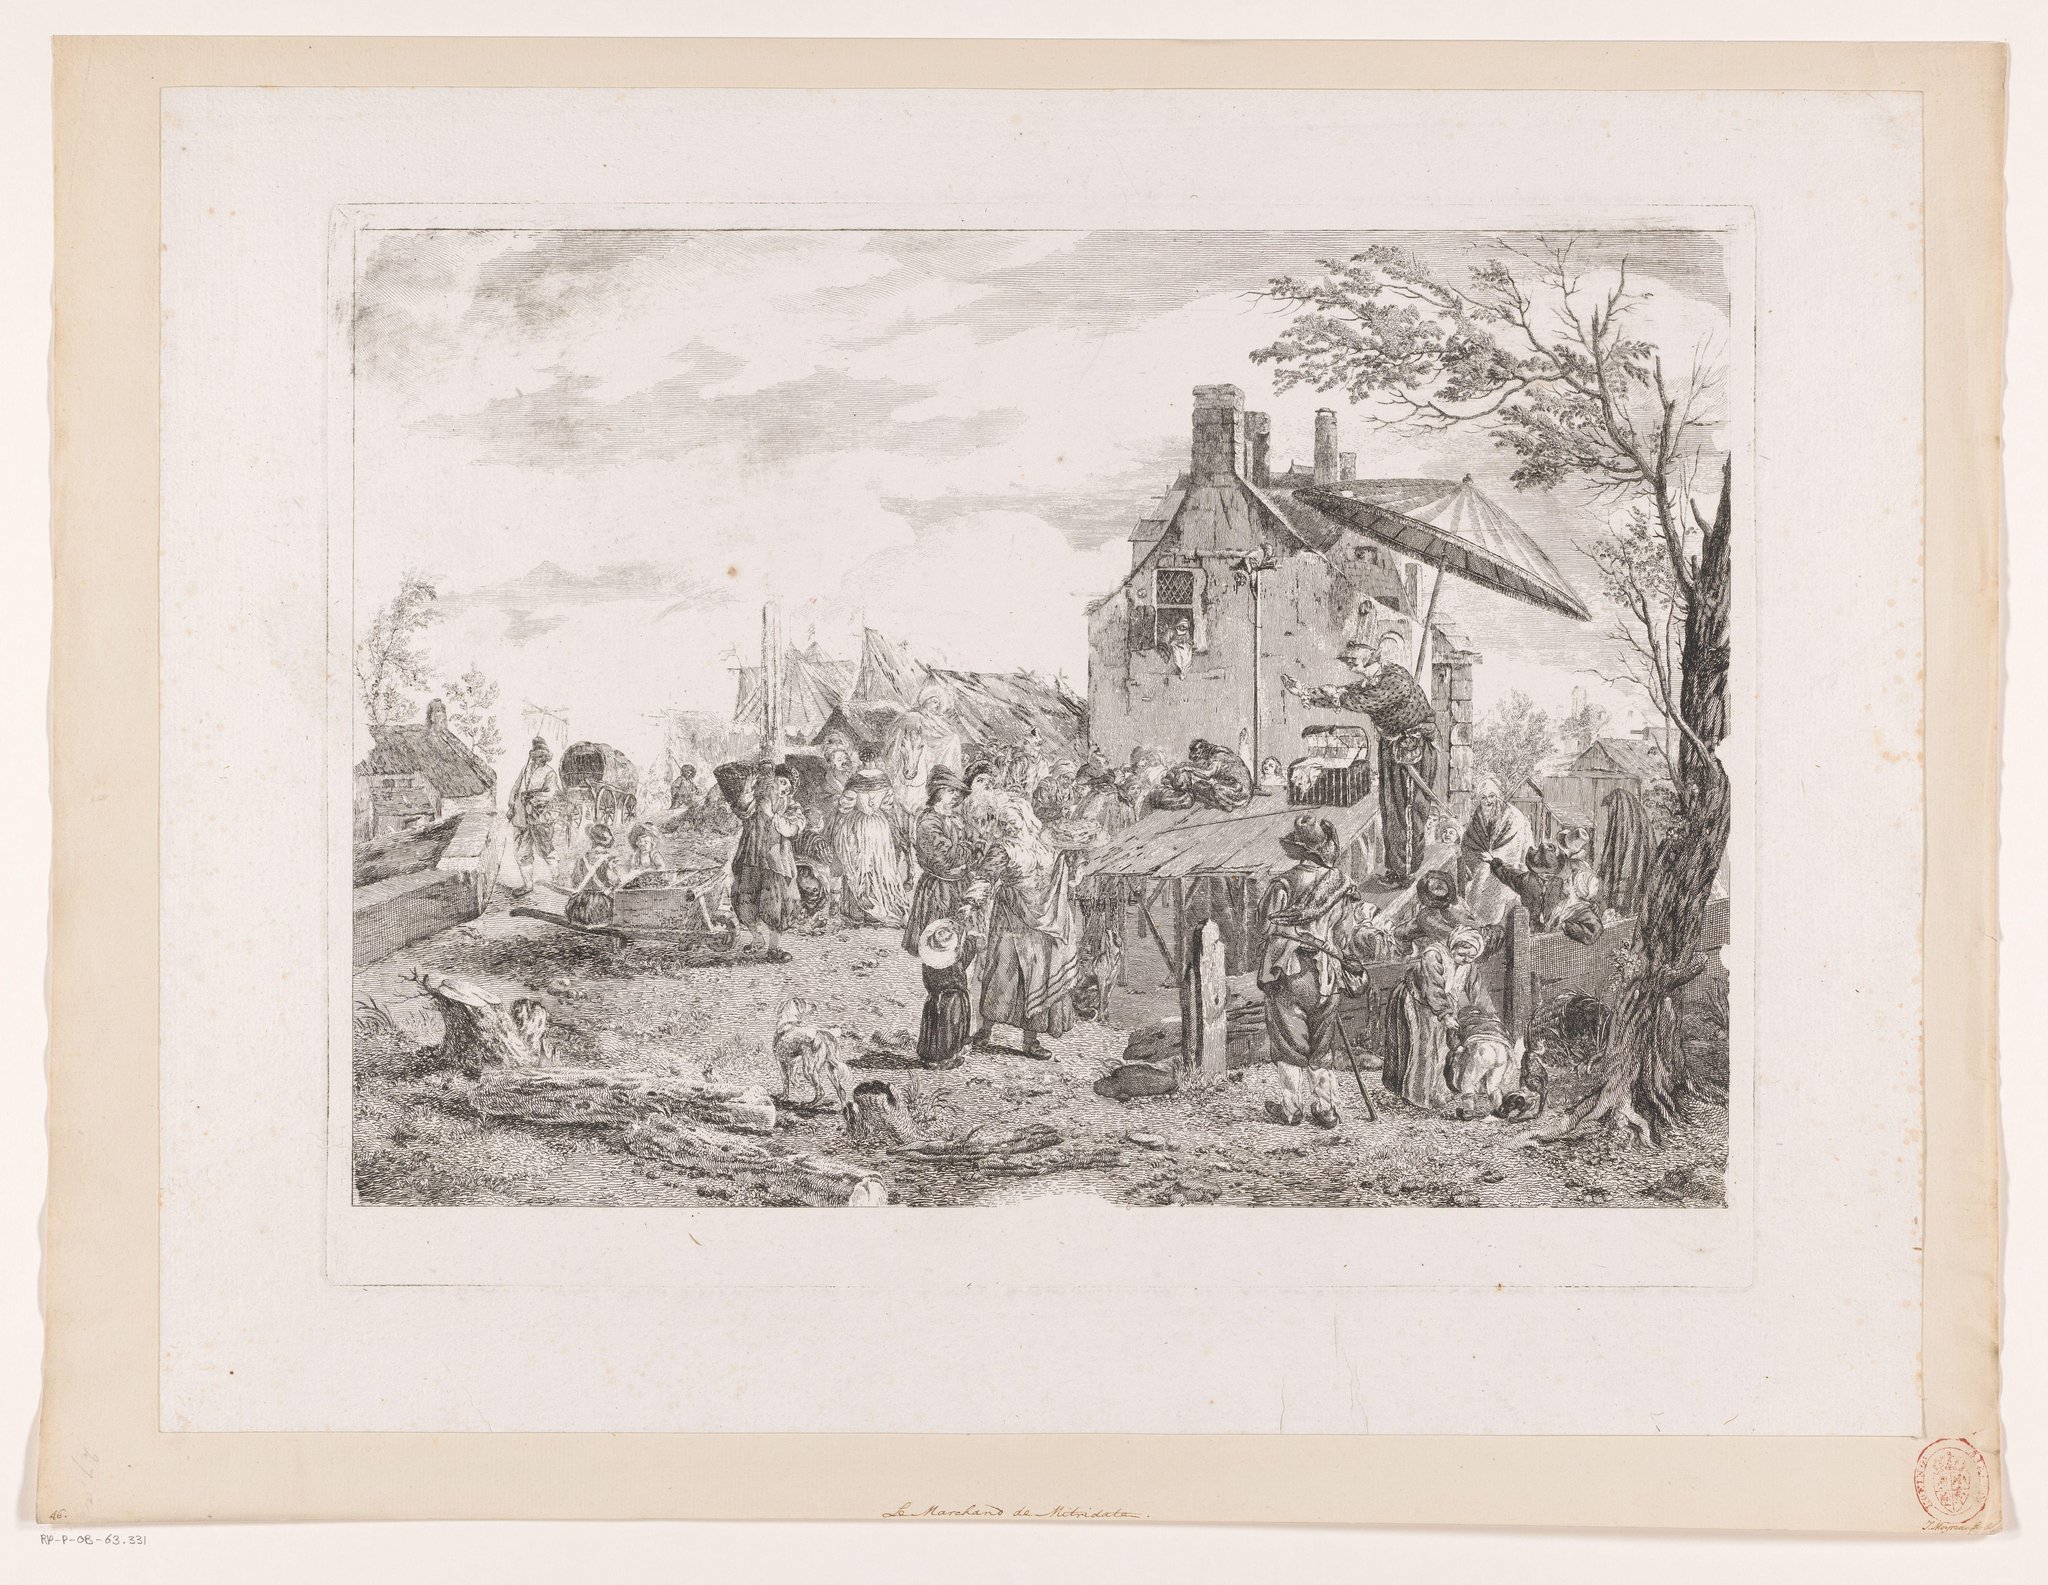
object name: print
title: Prenten naar schilderijen door Philips Wouwerman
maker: jean moyreau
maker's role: print maker, publisher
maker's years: 1690-1762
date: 1743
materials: paper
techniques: etching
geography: france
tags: theatre, theatrical performance, village, waffles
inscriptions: collector's mark: Lugt 240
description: Maakt deel uit van een serie van 89 prenten te dateren tussen ca. 1733-1762, naar het geschilderde oeuvre van Philips Wouwerman. Dit betreft plaat 46.